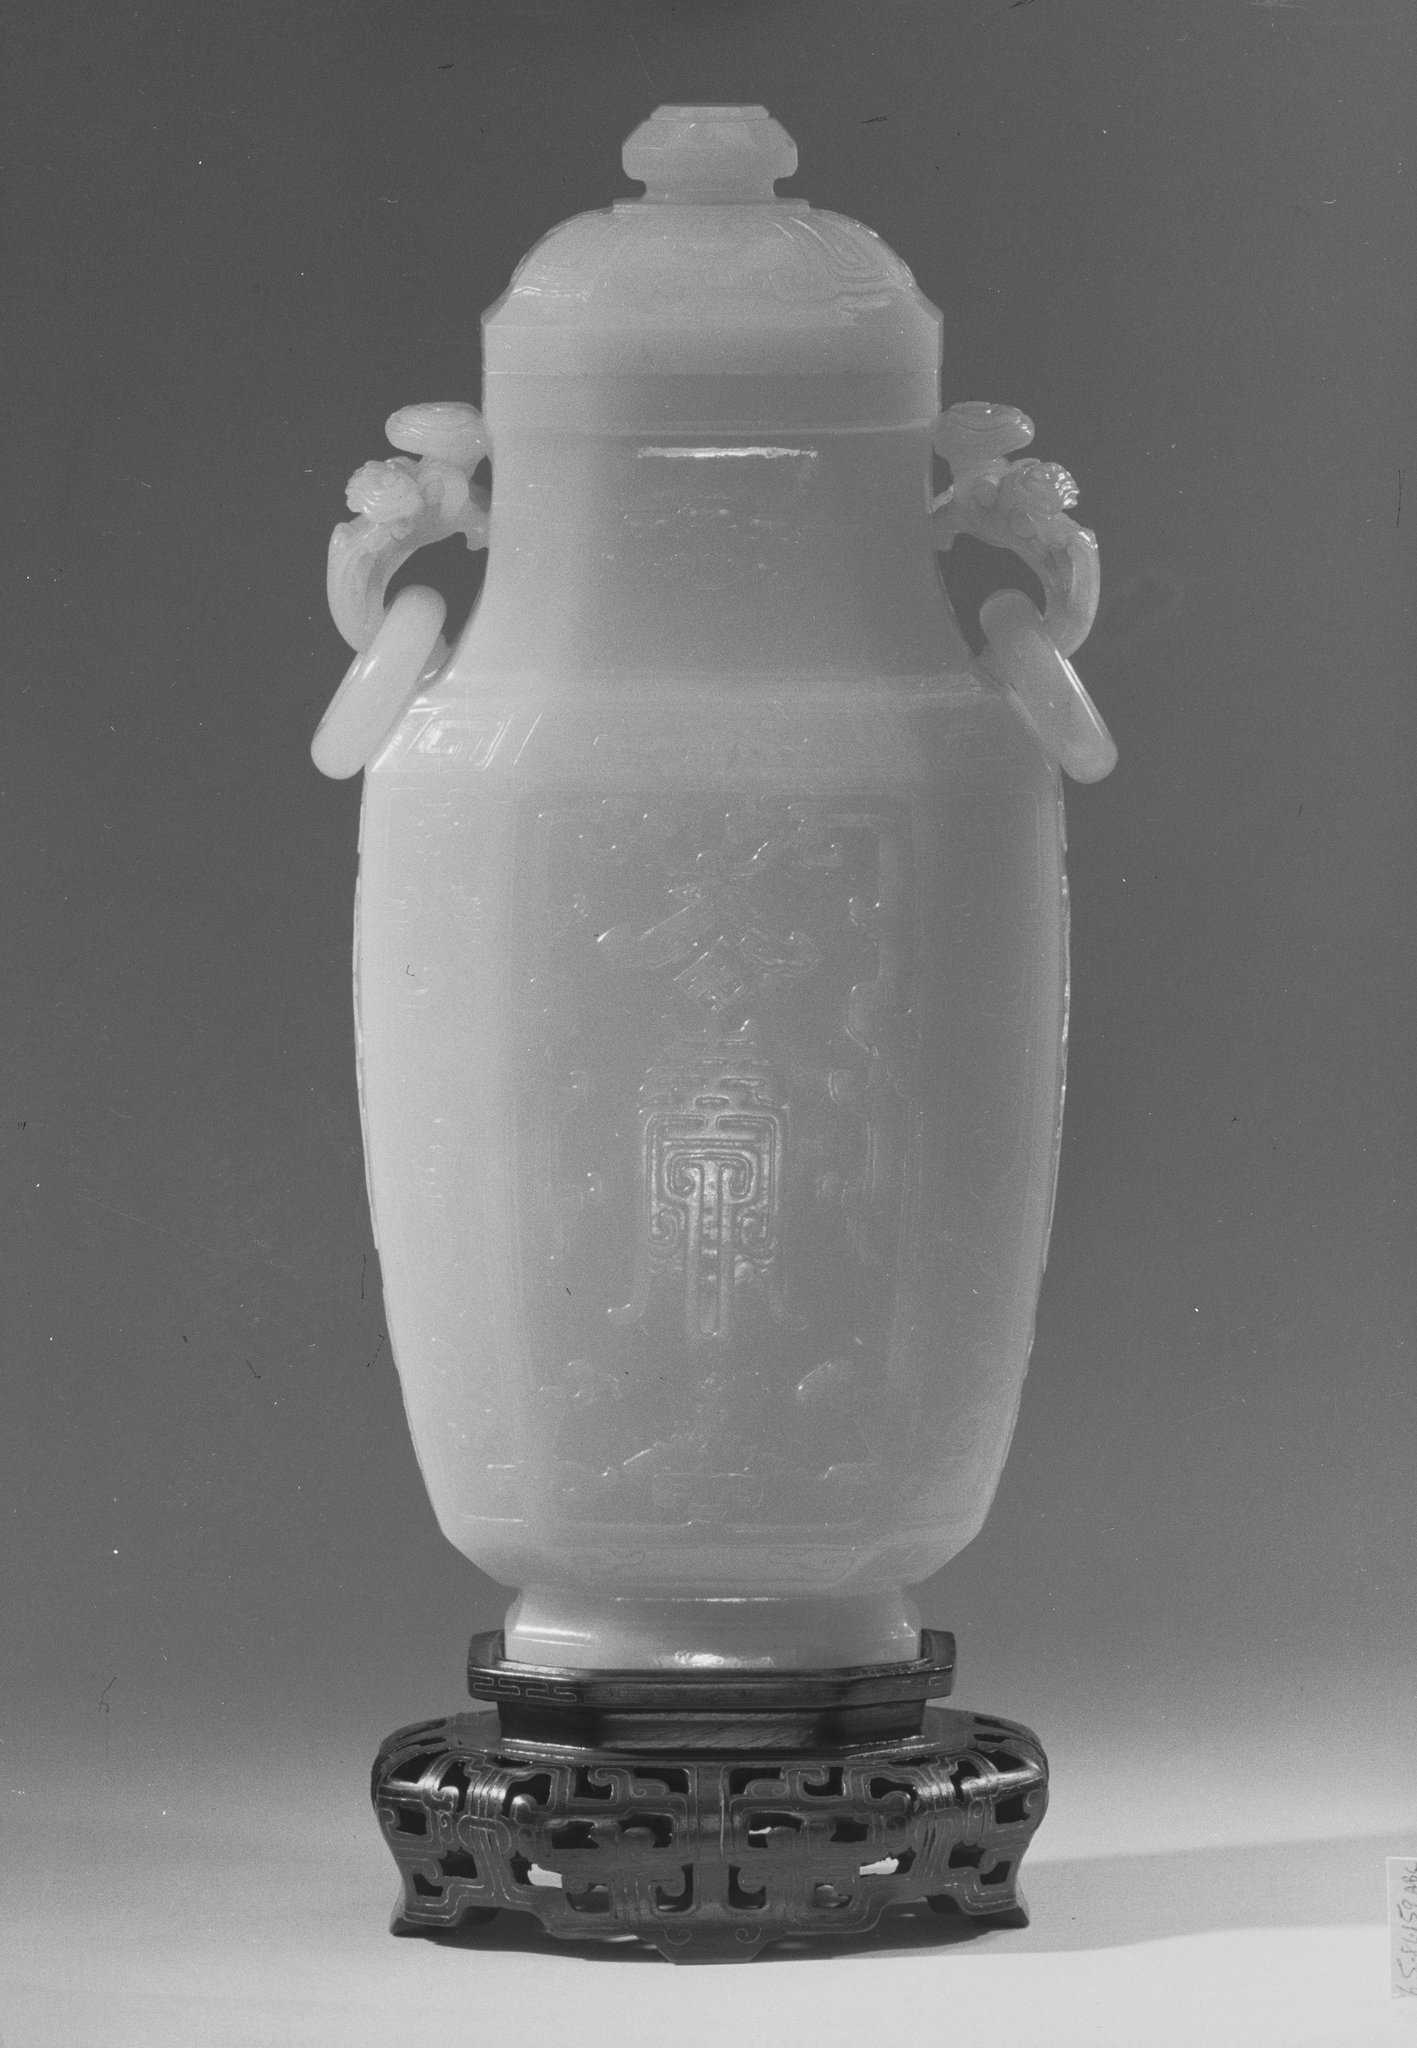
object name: covered vase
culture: chinese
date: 1701-1733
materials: jade